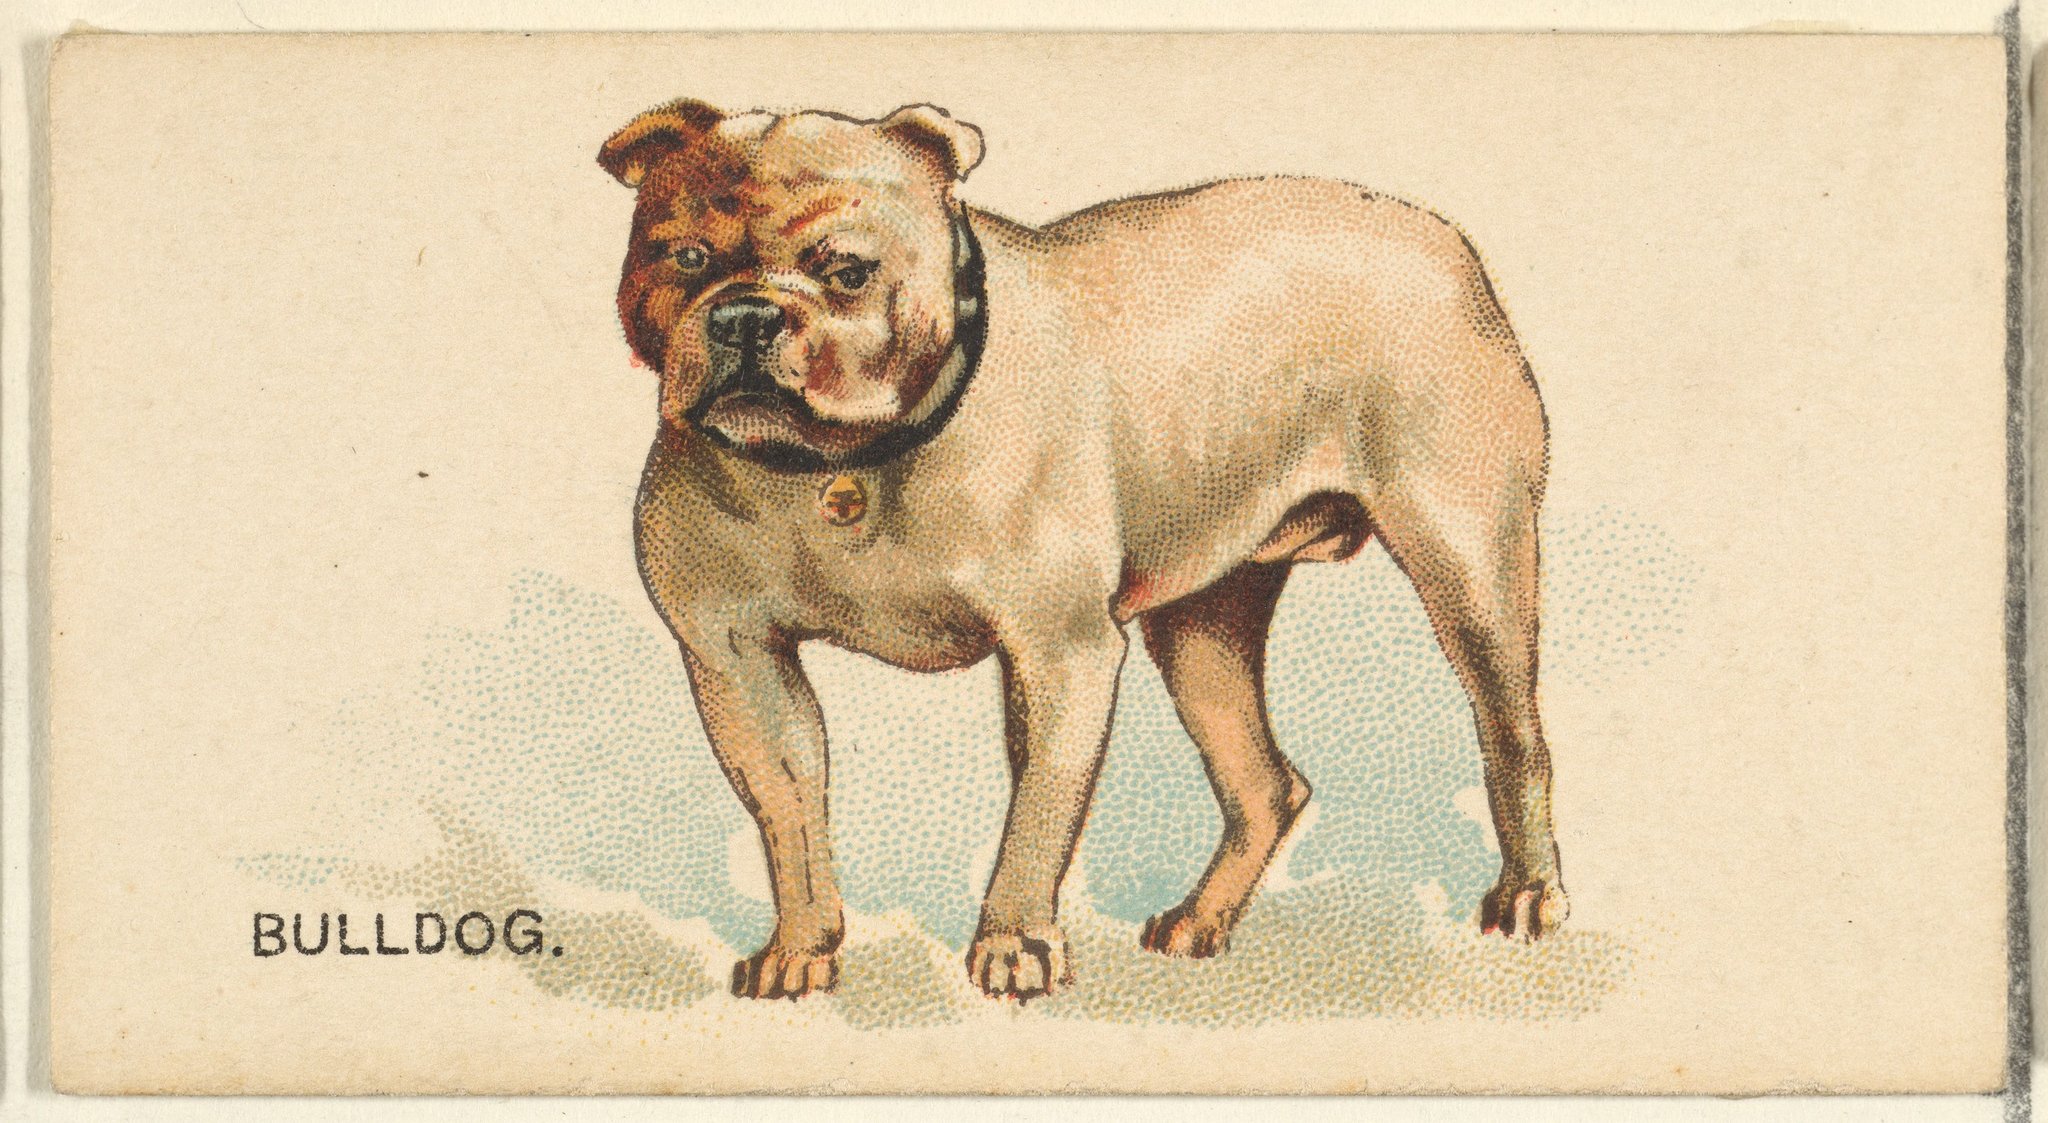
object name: print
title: Bulldog, from the Dogs of the World series for Old Judge Cigarettes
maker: goodwin & company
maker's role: publisher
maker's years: 1850-1950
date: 1890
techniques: color lithograph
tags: dogs